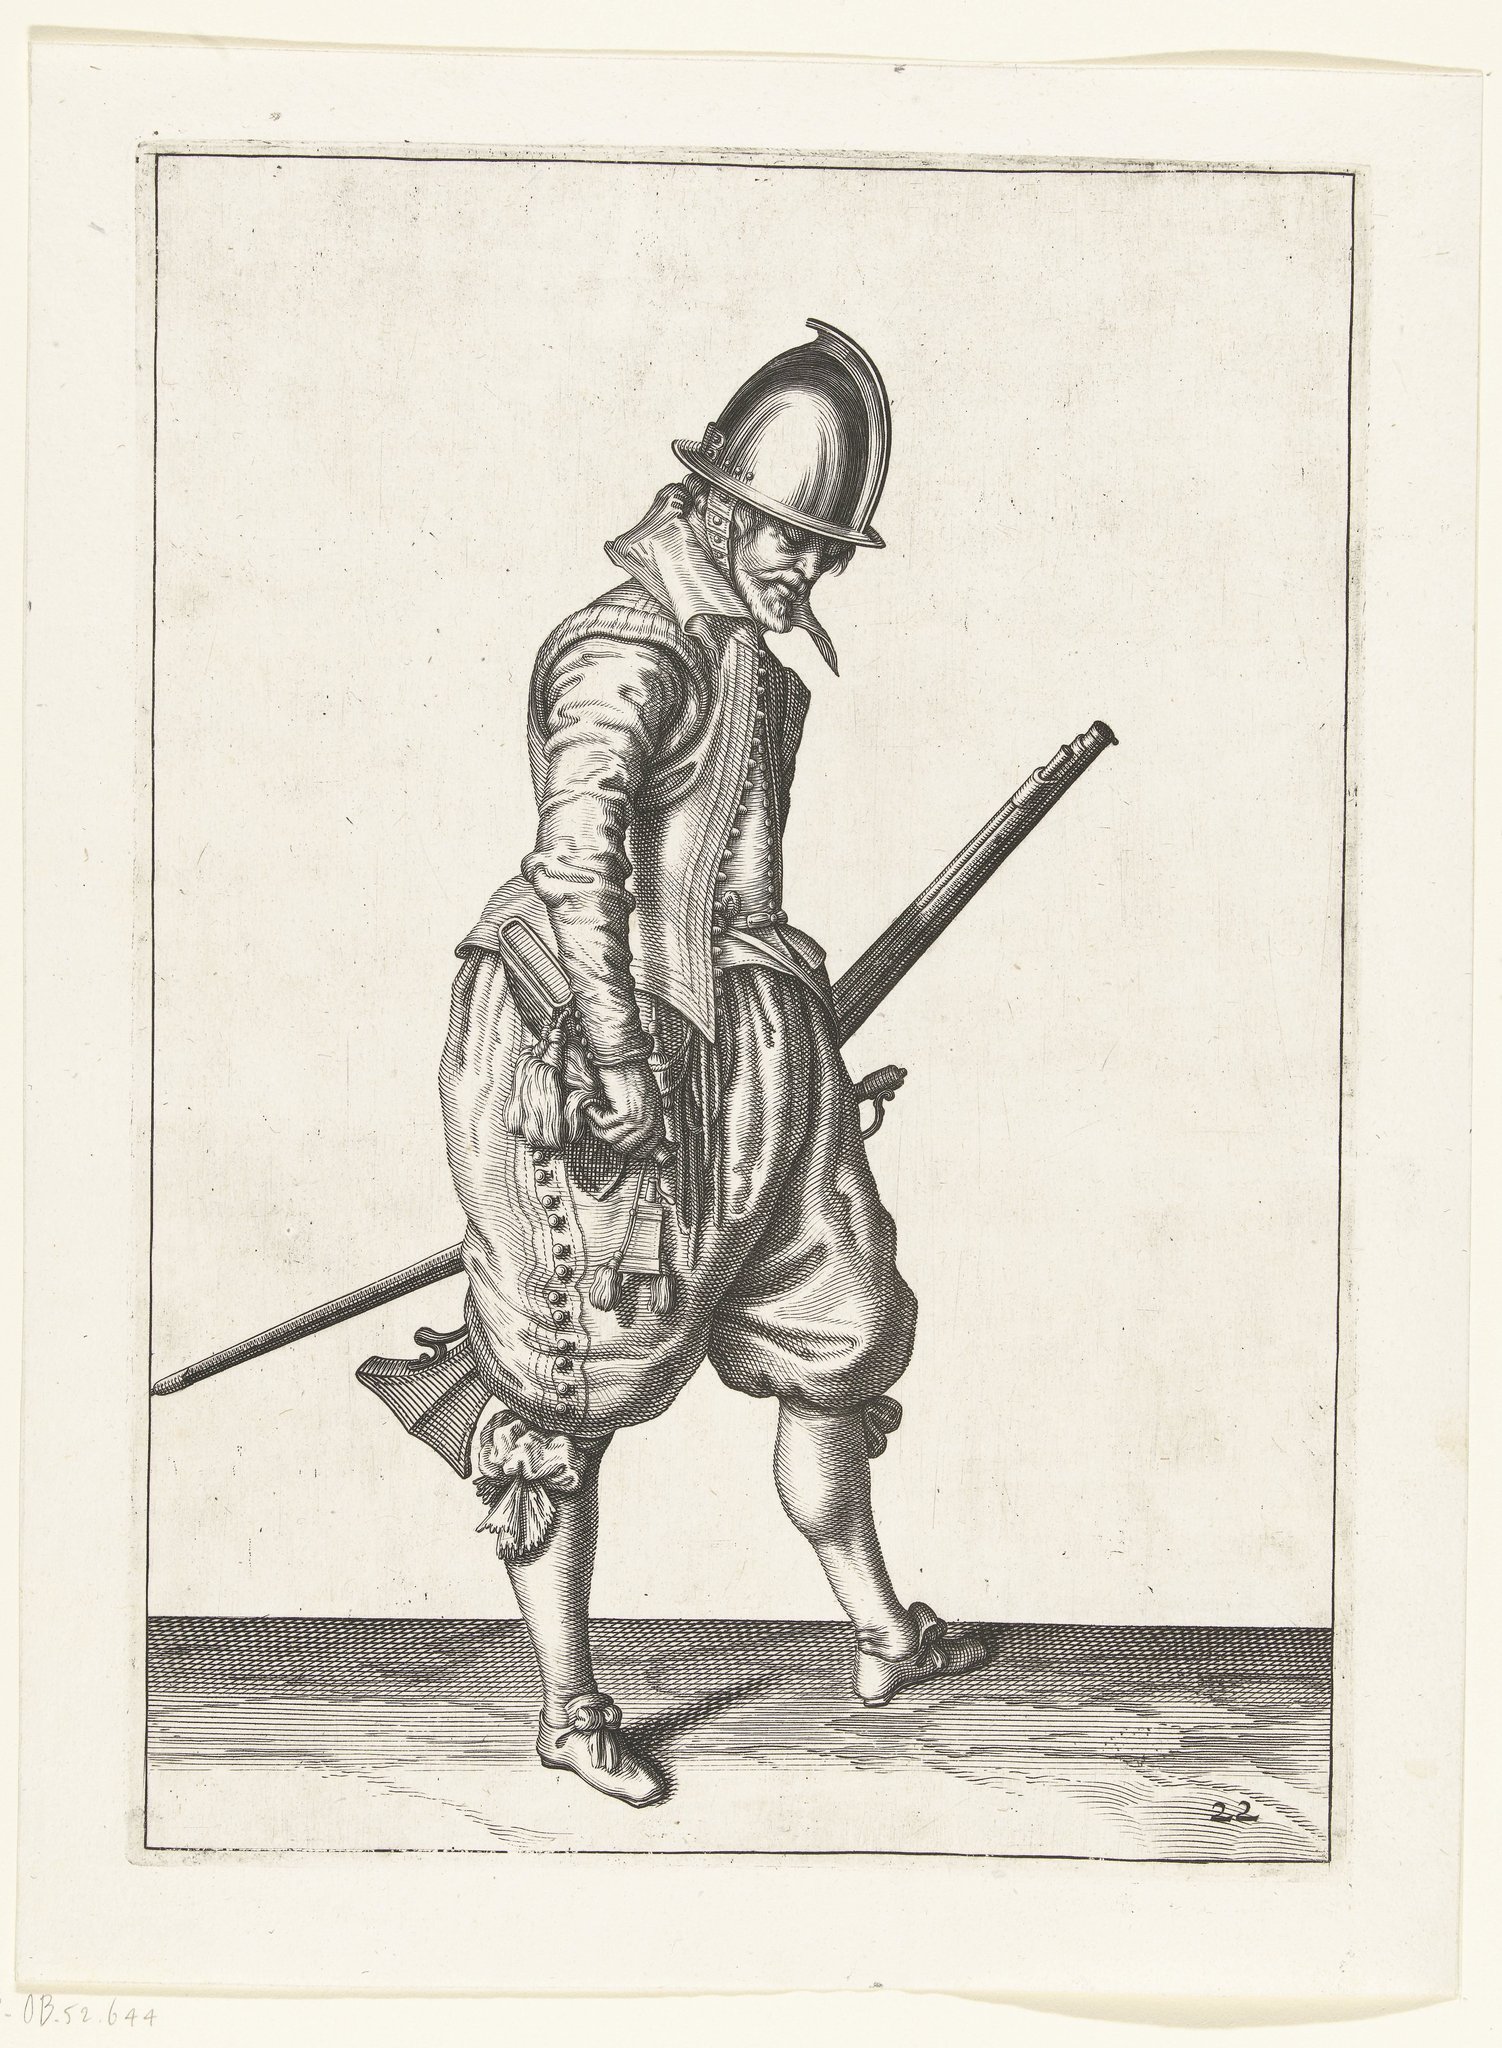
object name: print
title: Wapenhandelinghe van Roers Musquetten ende Spiessen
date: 1597-1607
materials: paper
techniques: engraving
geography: netherlands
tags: manoeuvre ~ military training, firearms: rifle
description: Een soldaat, ten voeten uit, naar rechts, die met zijn linkerhand bij zijn linkerdijbeen een roer (een bepaald type vuurwapen) vasthoudt, de loop schuin omhoog wijzend. Met zijn rechterhand opent hij een kruithoorn. Deze prent is onderdeel van de reeks van 42 genummerde prenten van roerschutters uit de Wapenhandelinghe.